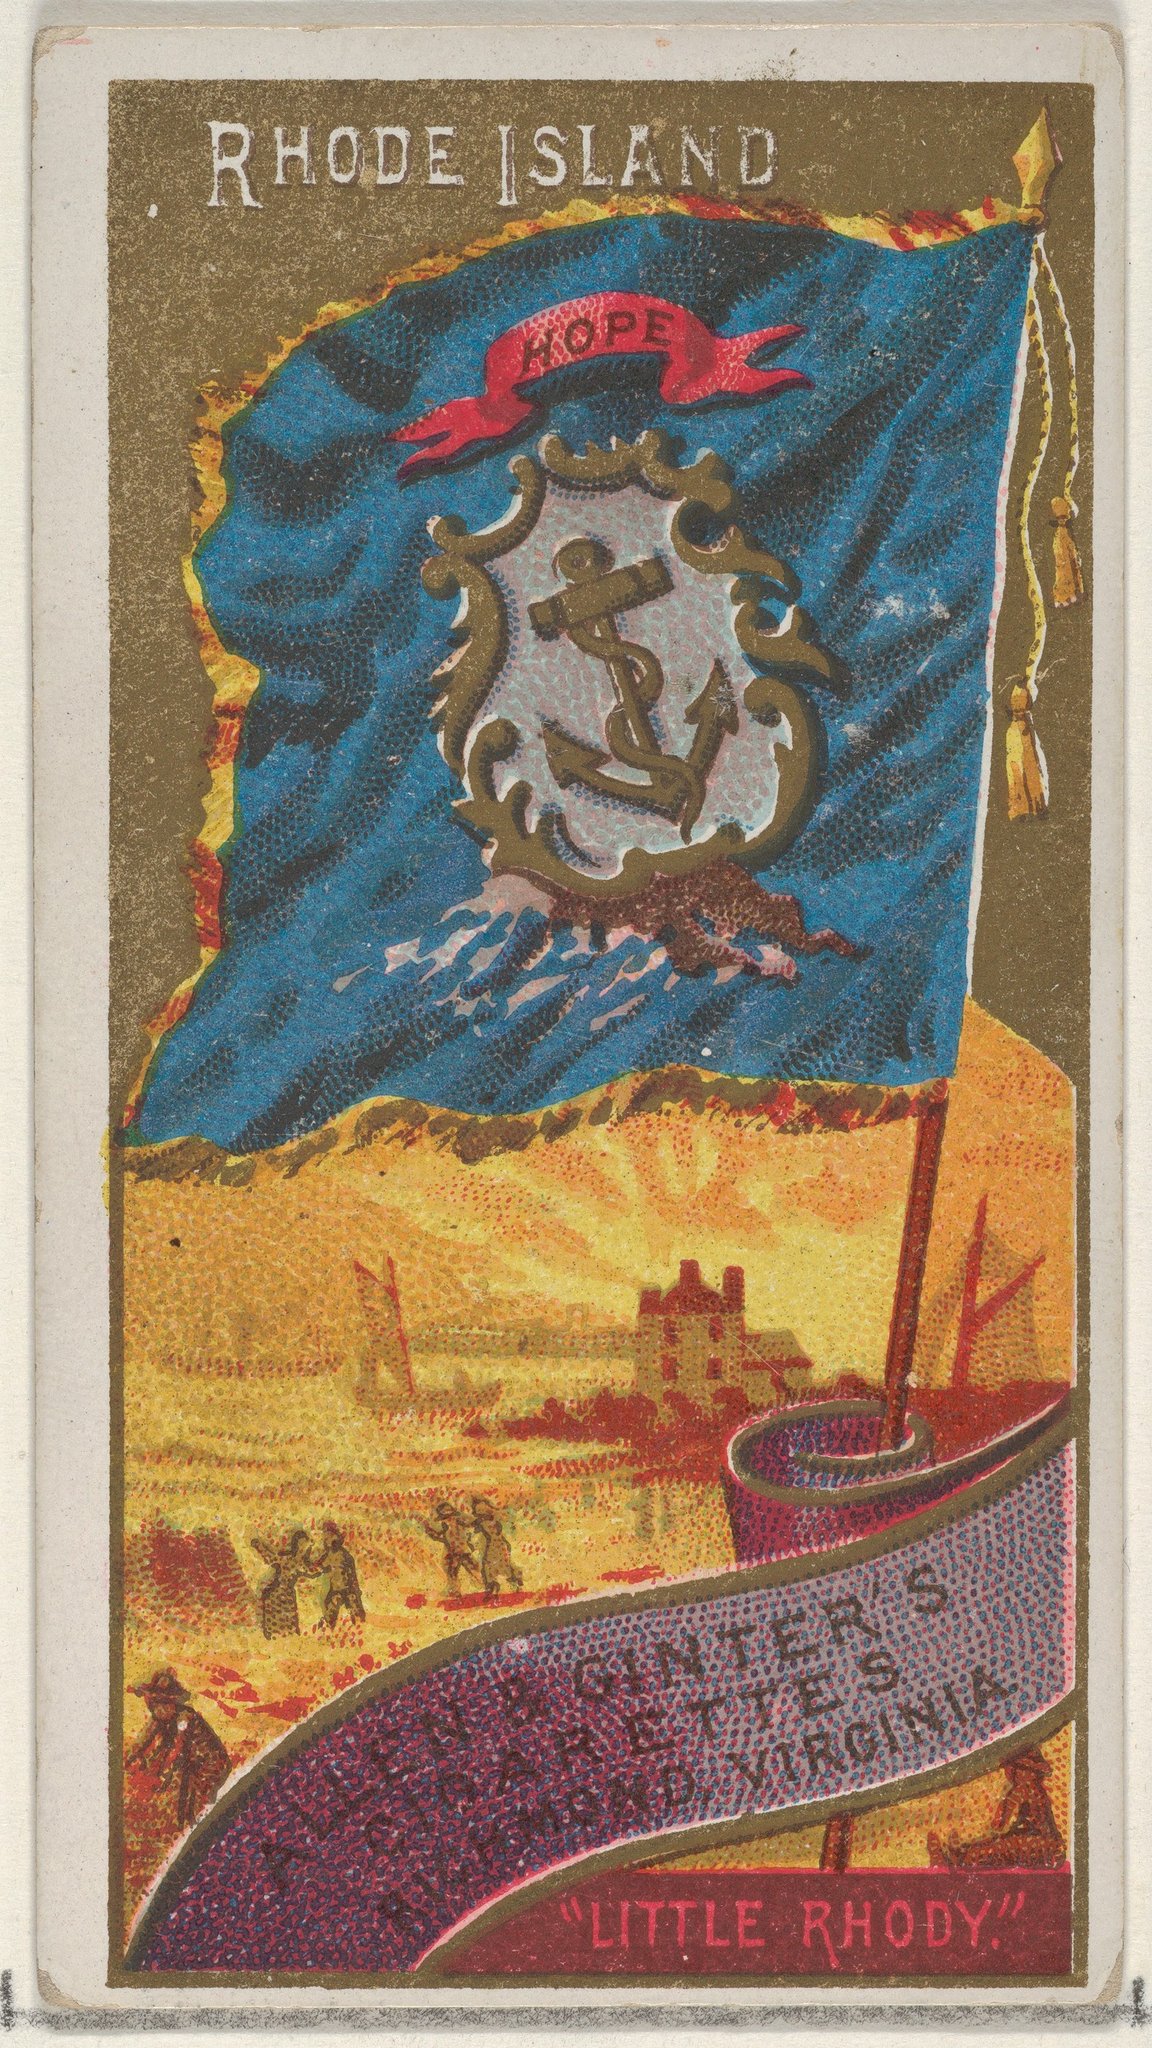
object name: print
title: Rhode Island, from Flags of the States and Territories (N11) for Allen & Ginter Cigarettes Brands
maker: allen & ginter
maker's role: publisher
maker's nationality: american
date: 1888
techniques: color lithograph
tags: flags